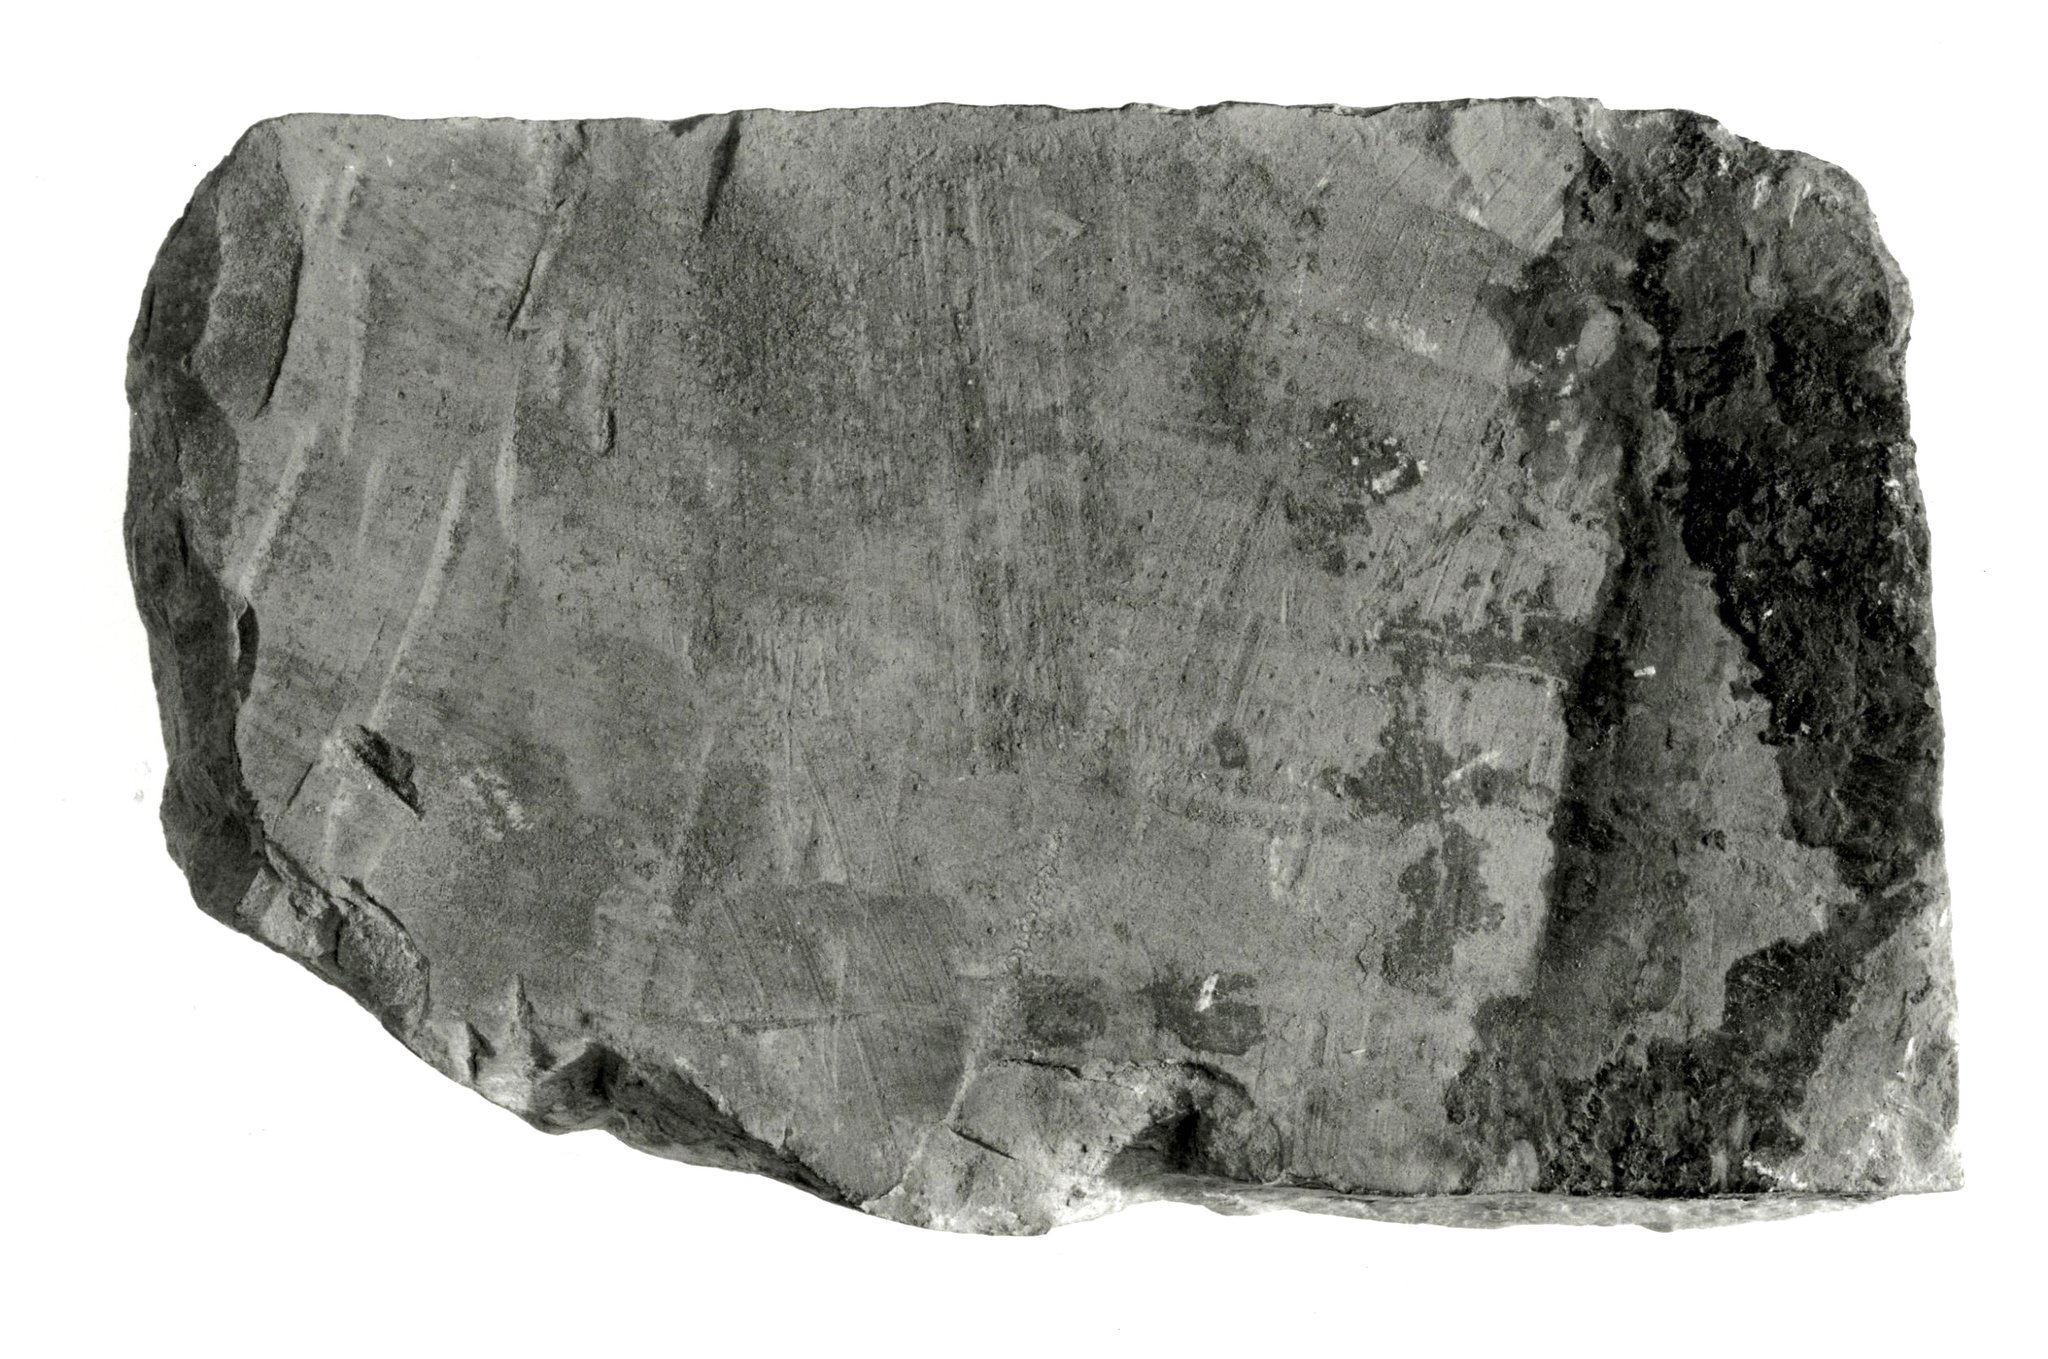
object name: relief, tomb of nespekashuty, wall casing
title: Wall casing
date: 664-610 BCE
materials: limestone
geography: egypt